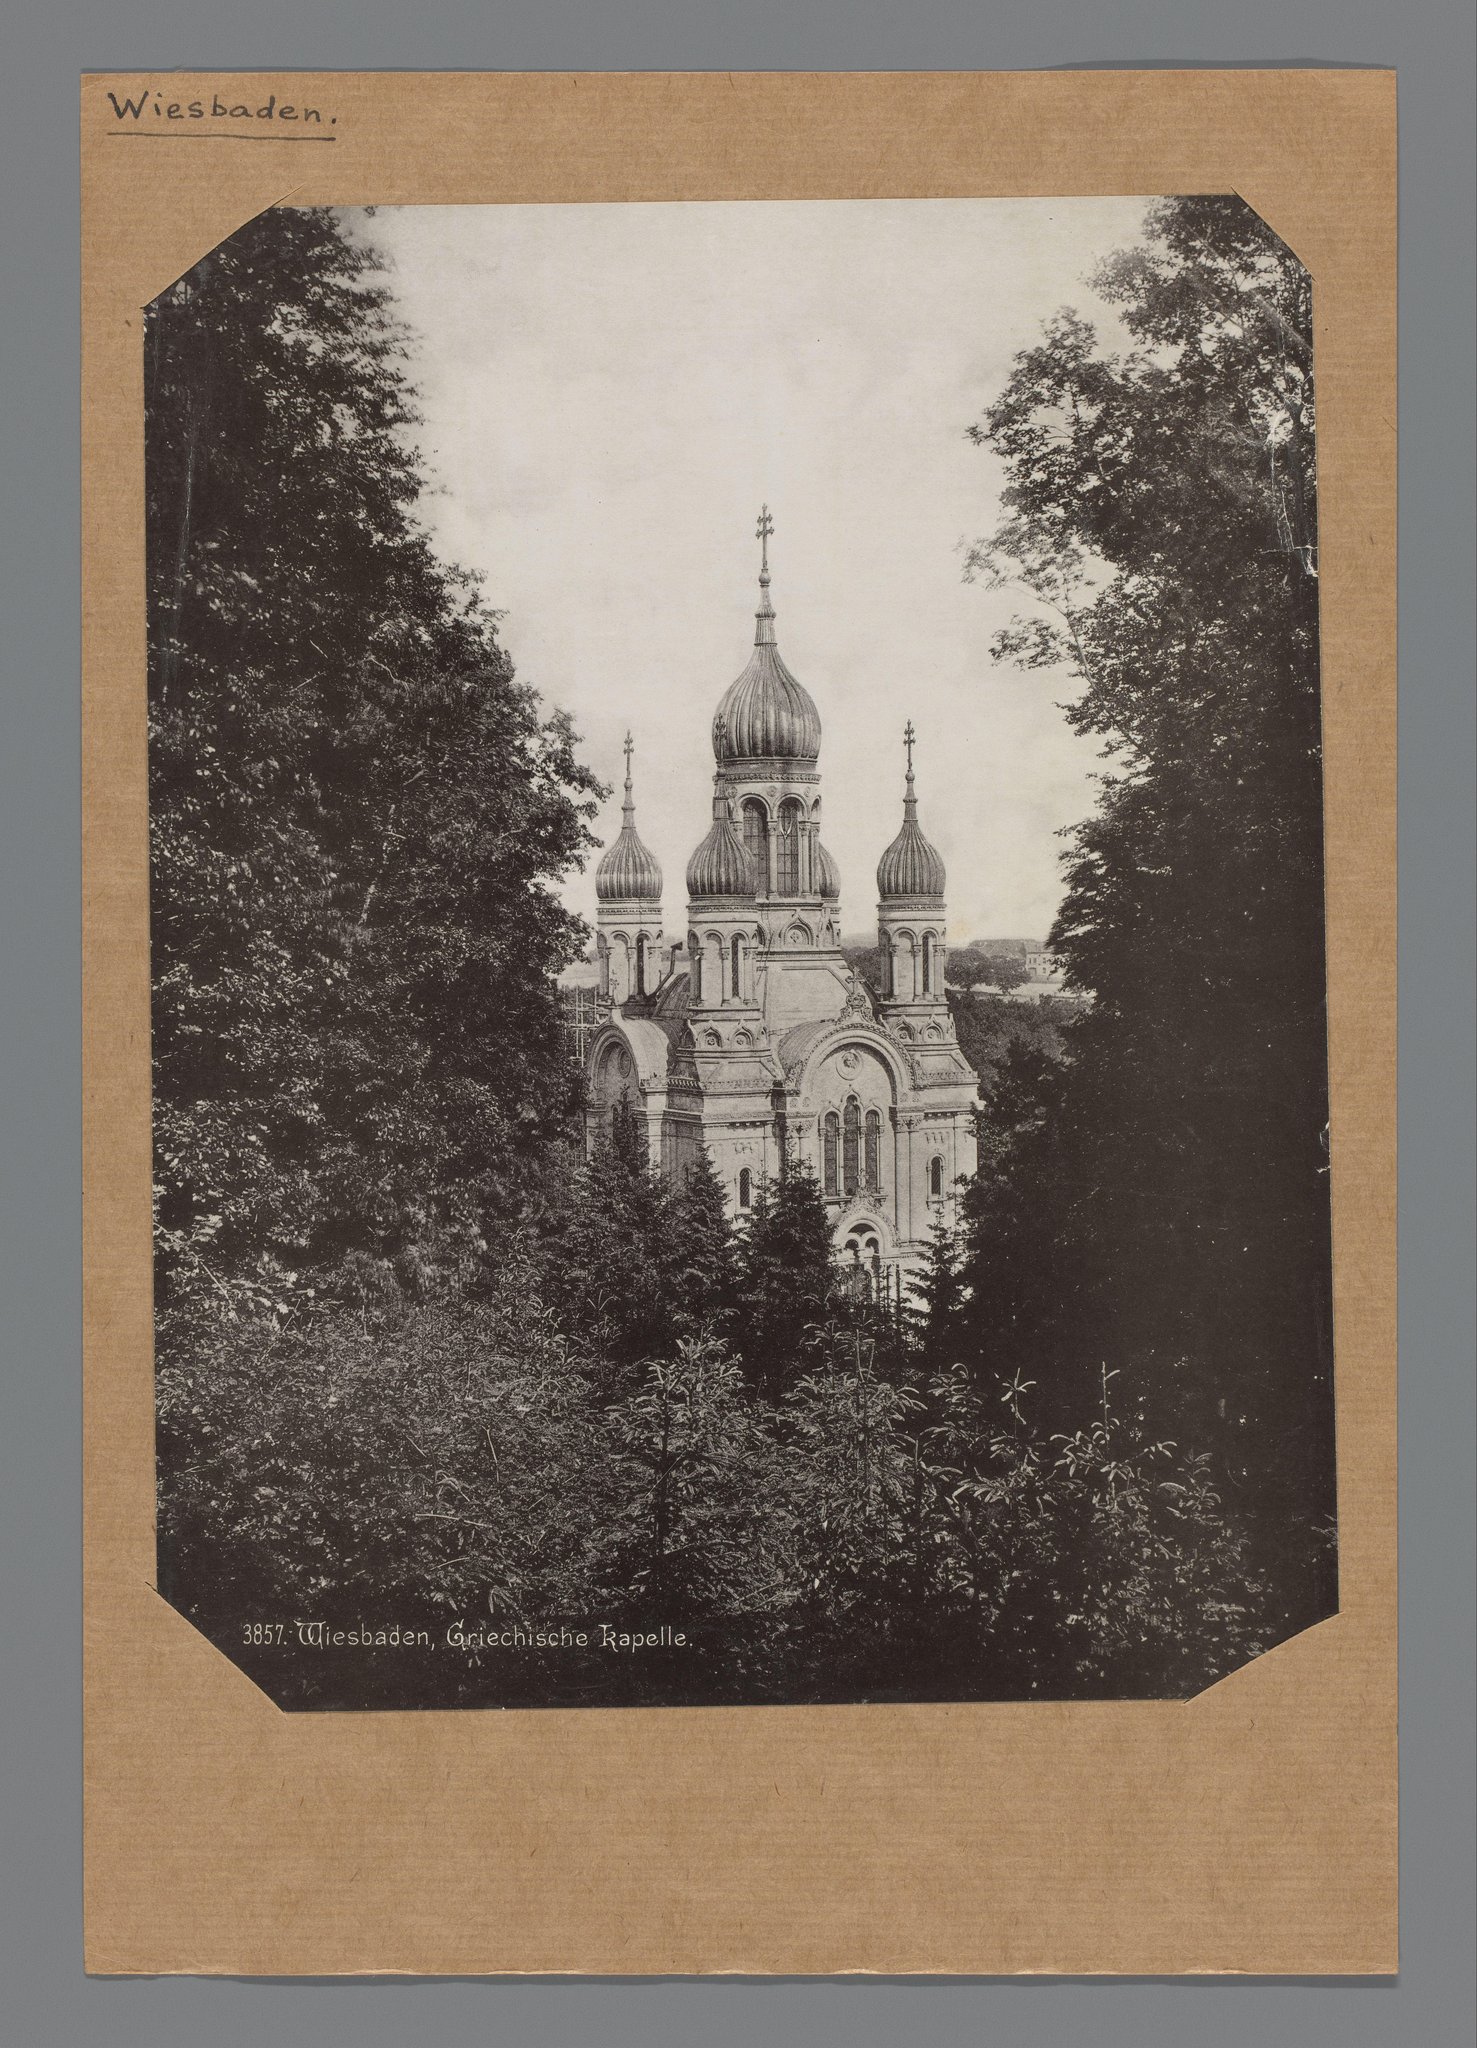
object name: photograph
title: Wiesbaden, Griechische Kapelle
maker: Anonymous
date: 1900-1950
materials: paper, photographic support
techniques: photograph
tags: wiesbaden